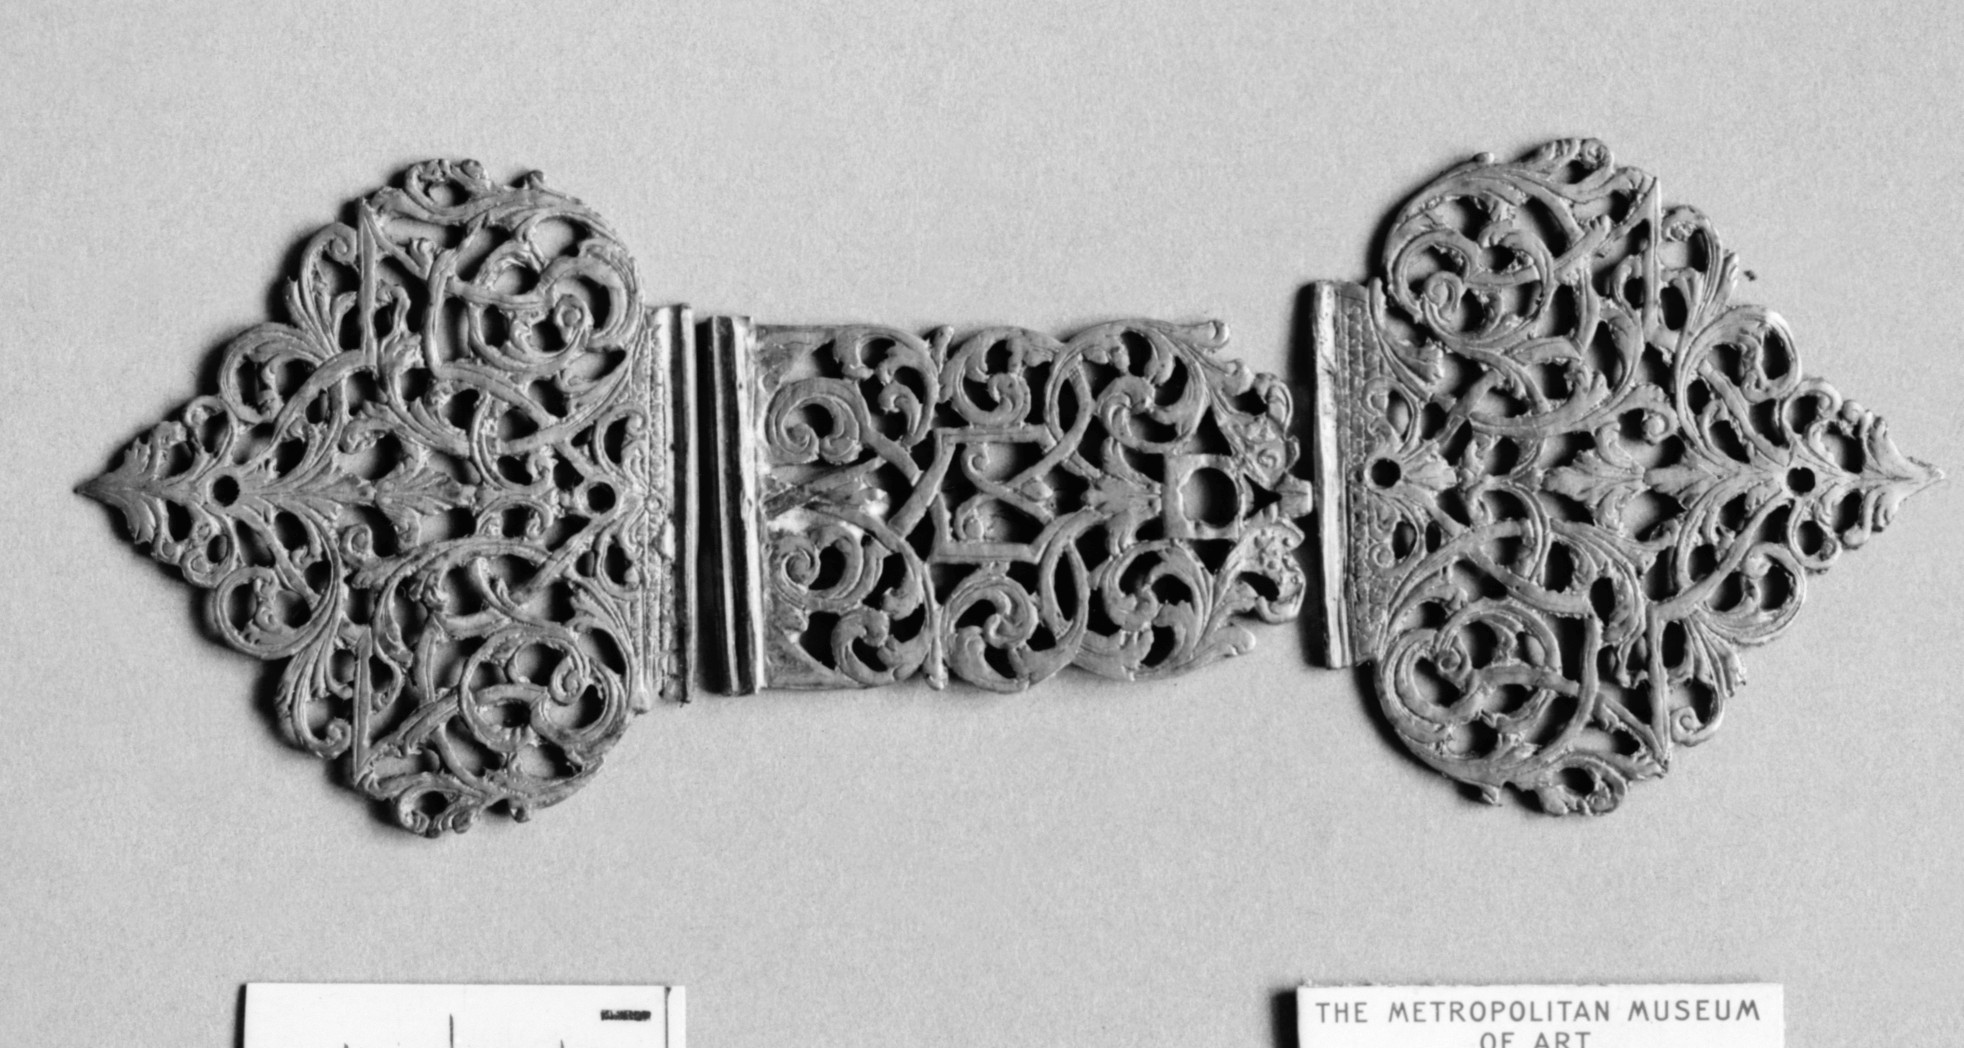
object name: book clasp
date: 1701-1800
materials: silver